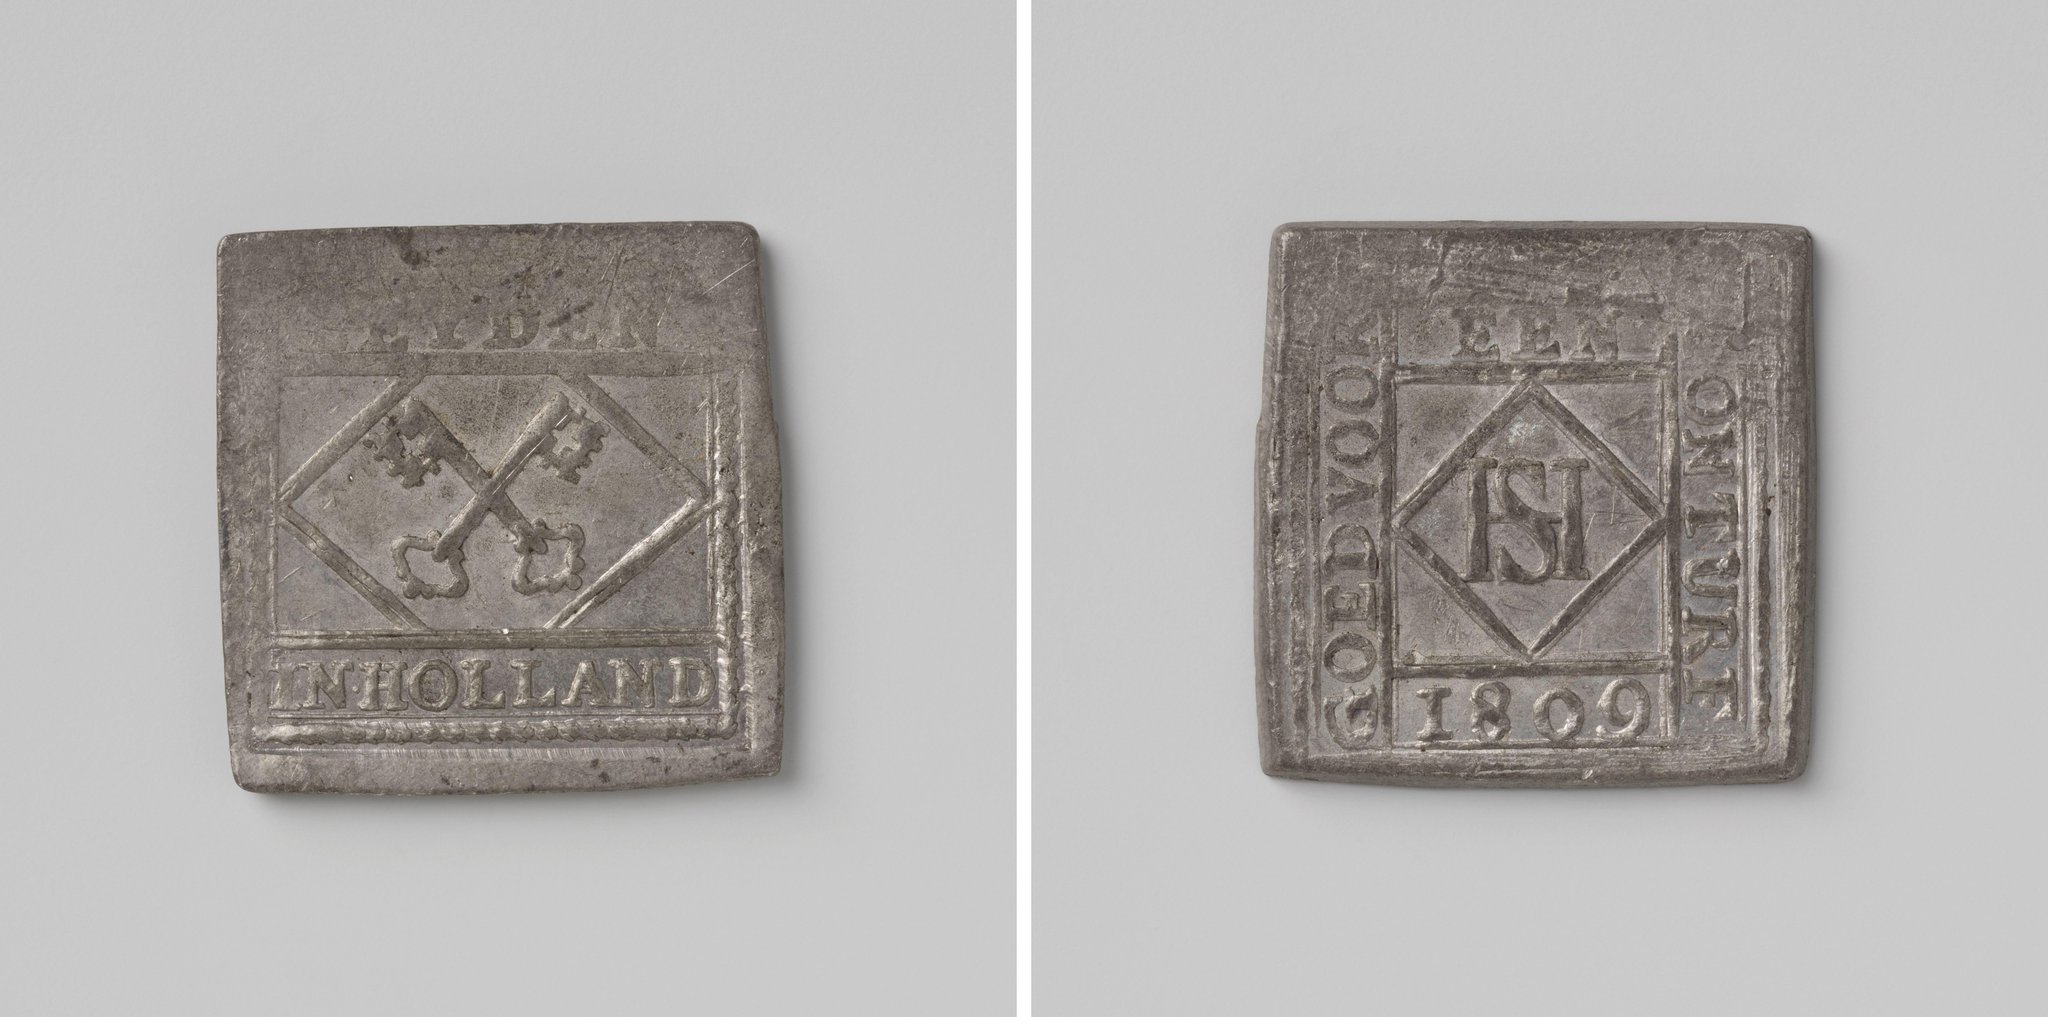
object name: loden penning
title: Huiszittenhuis te Leiden, armenpenning die bij uitdeling recht gaf op een ton turf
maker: Anonymous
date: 1809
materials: lead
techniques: striking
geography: leiden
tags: leiden